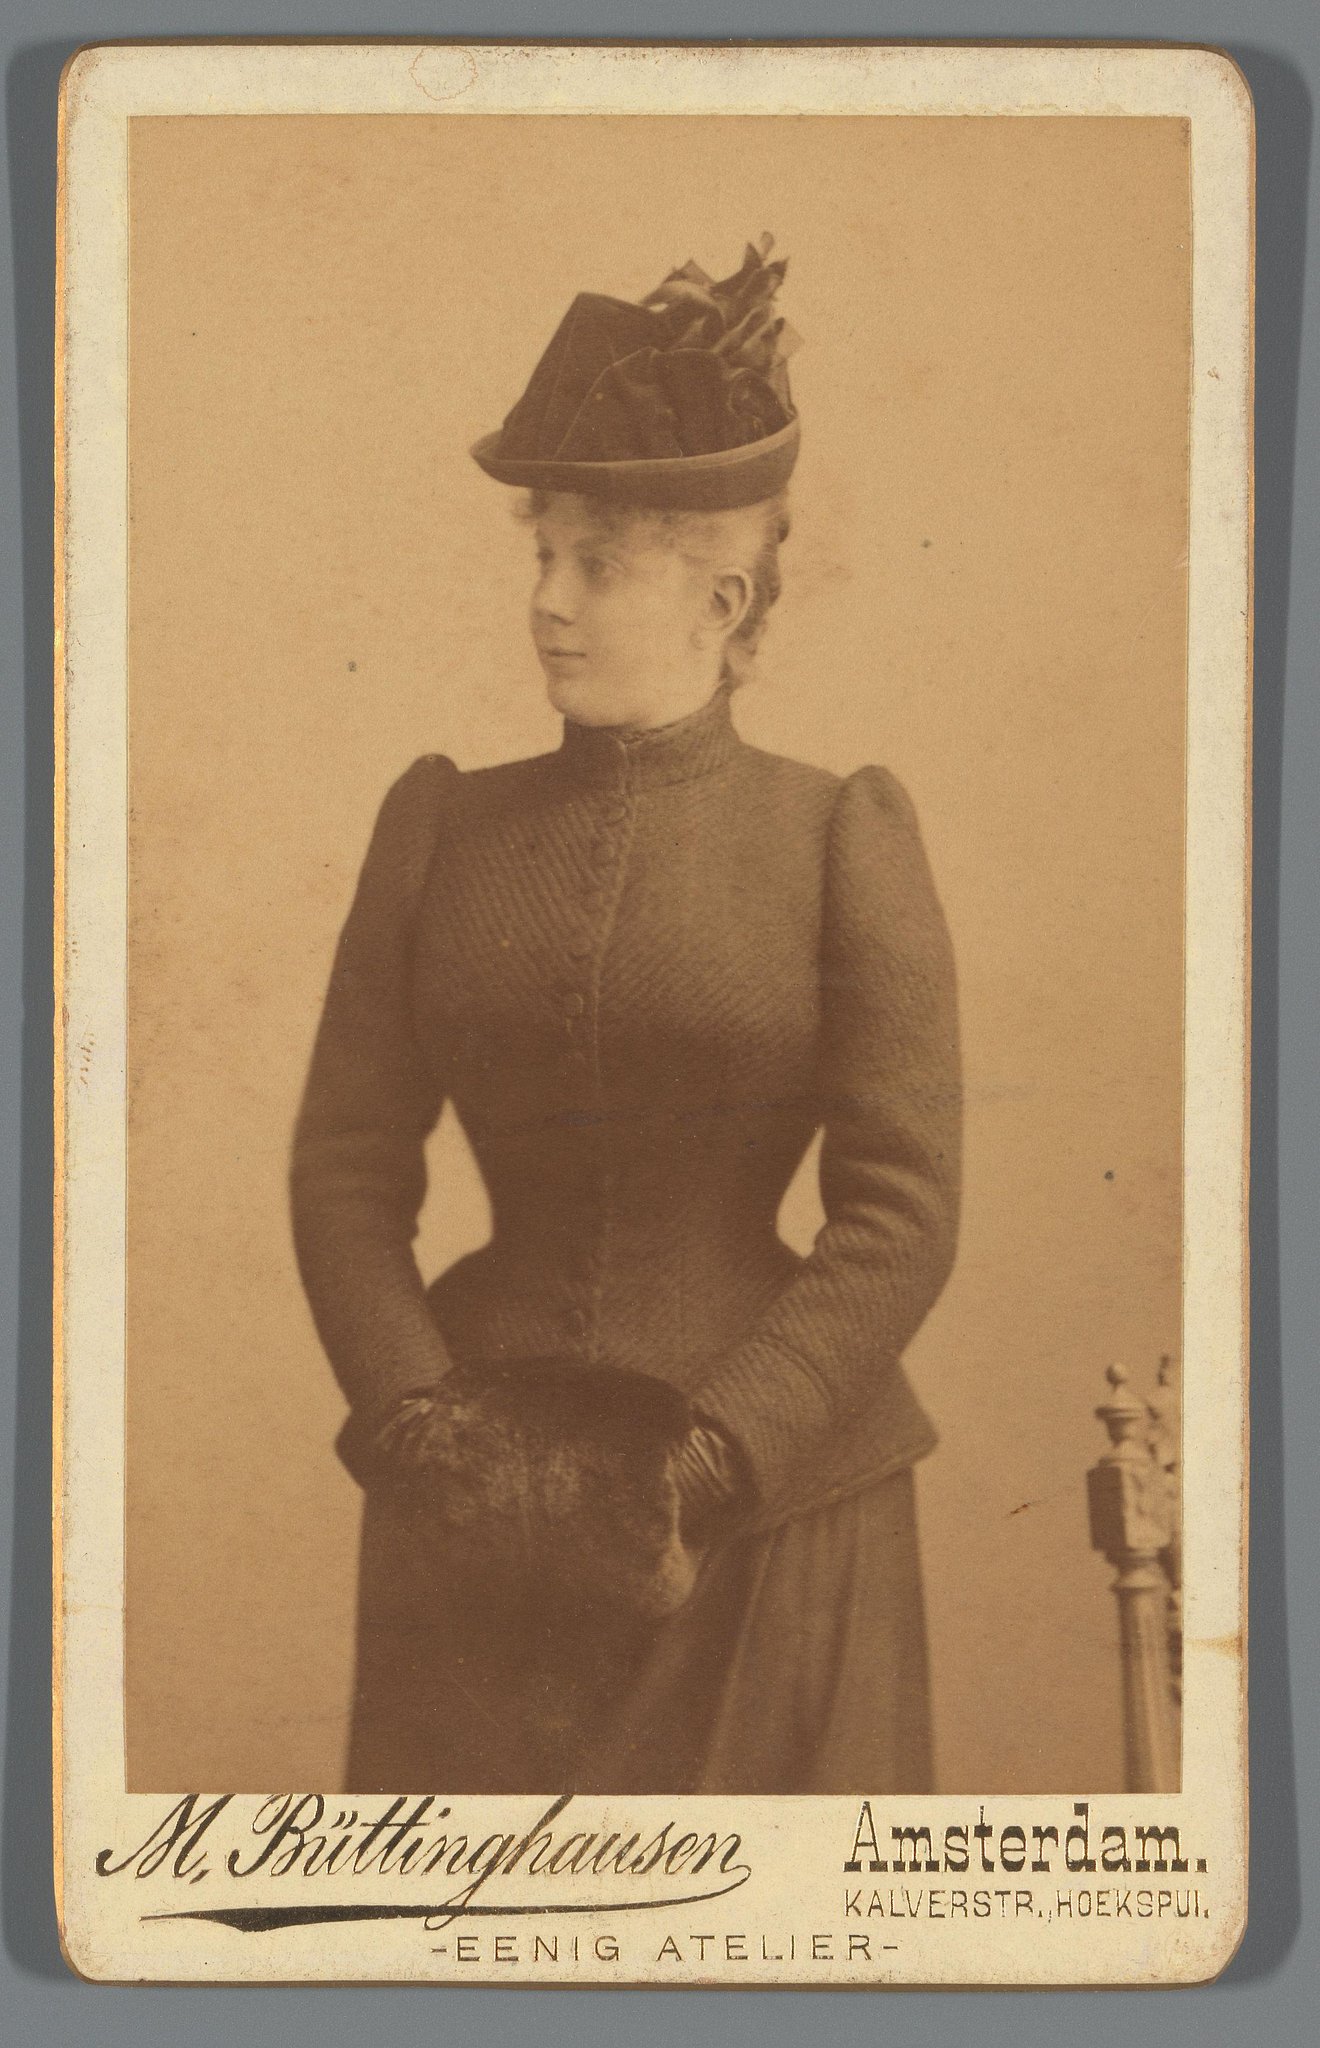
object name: carte de visite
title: Tante Pau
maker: max büttinghausen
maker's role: fotograaf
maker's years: 1847-1906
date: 1855-1910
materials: photographic support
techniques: carbon print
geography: amsterdam